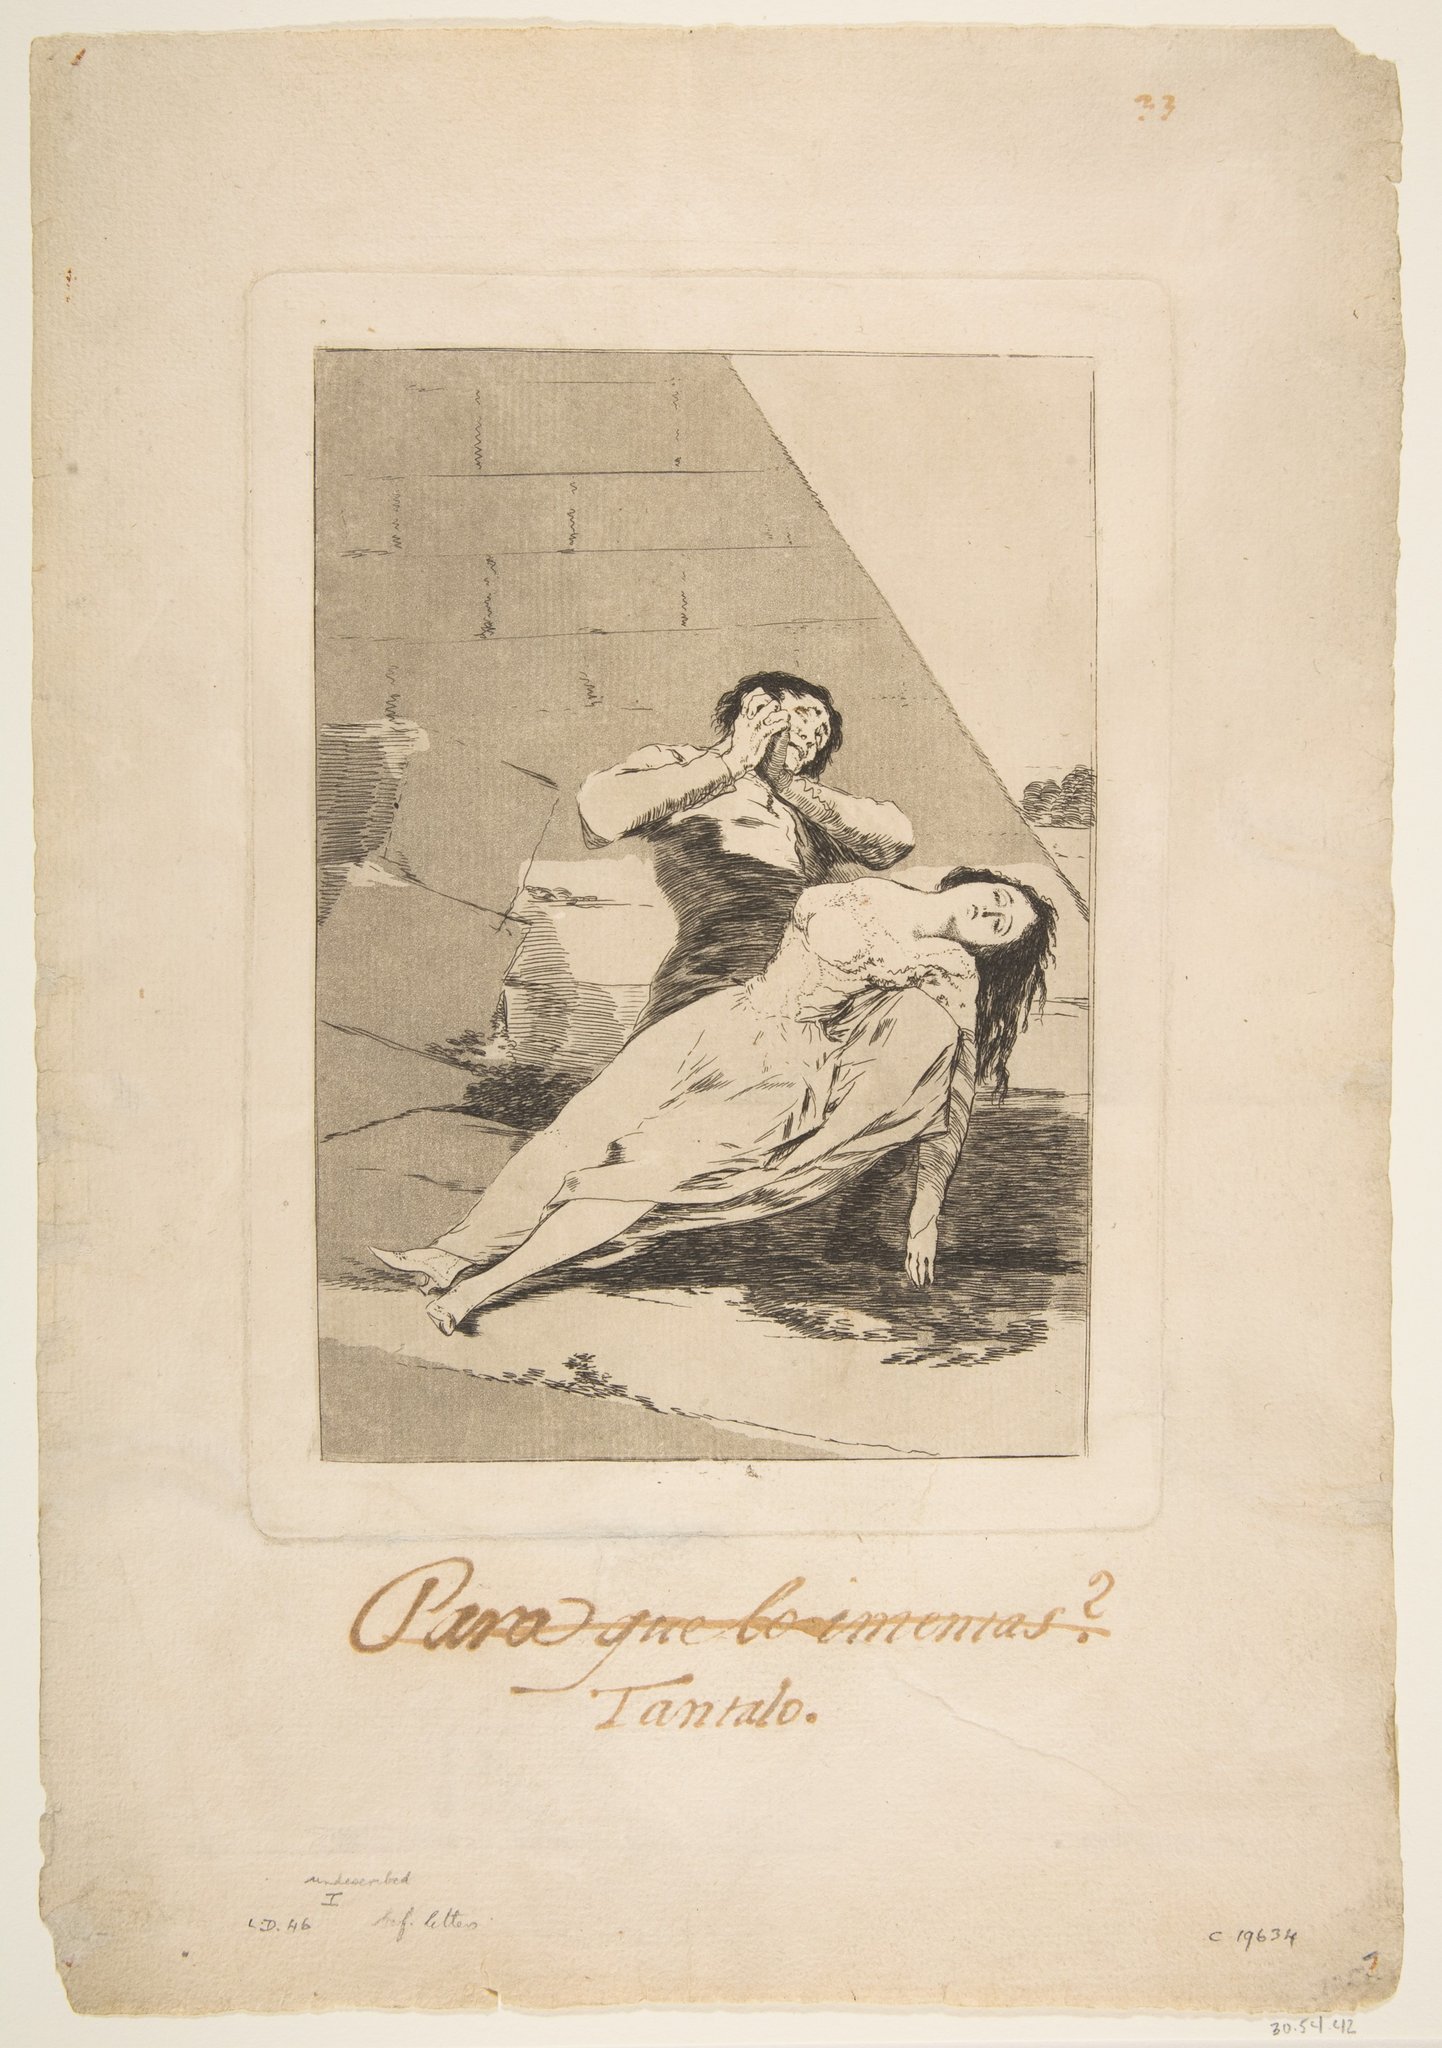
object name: print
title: Plate 9 from 'Los Caprichos': Tantalus (Tantalo.)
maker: goya (francisco de goya y lucientes)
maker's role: artist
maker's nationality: spanish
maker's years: 1746-1828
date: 1798-1799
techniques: aquatint, burnishing, etching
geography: spain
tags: sadness,men,women,death